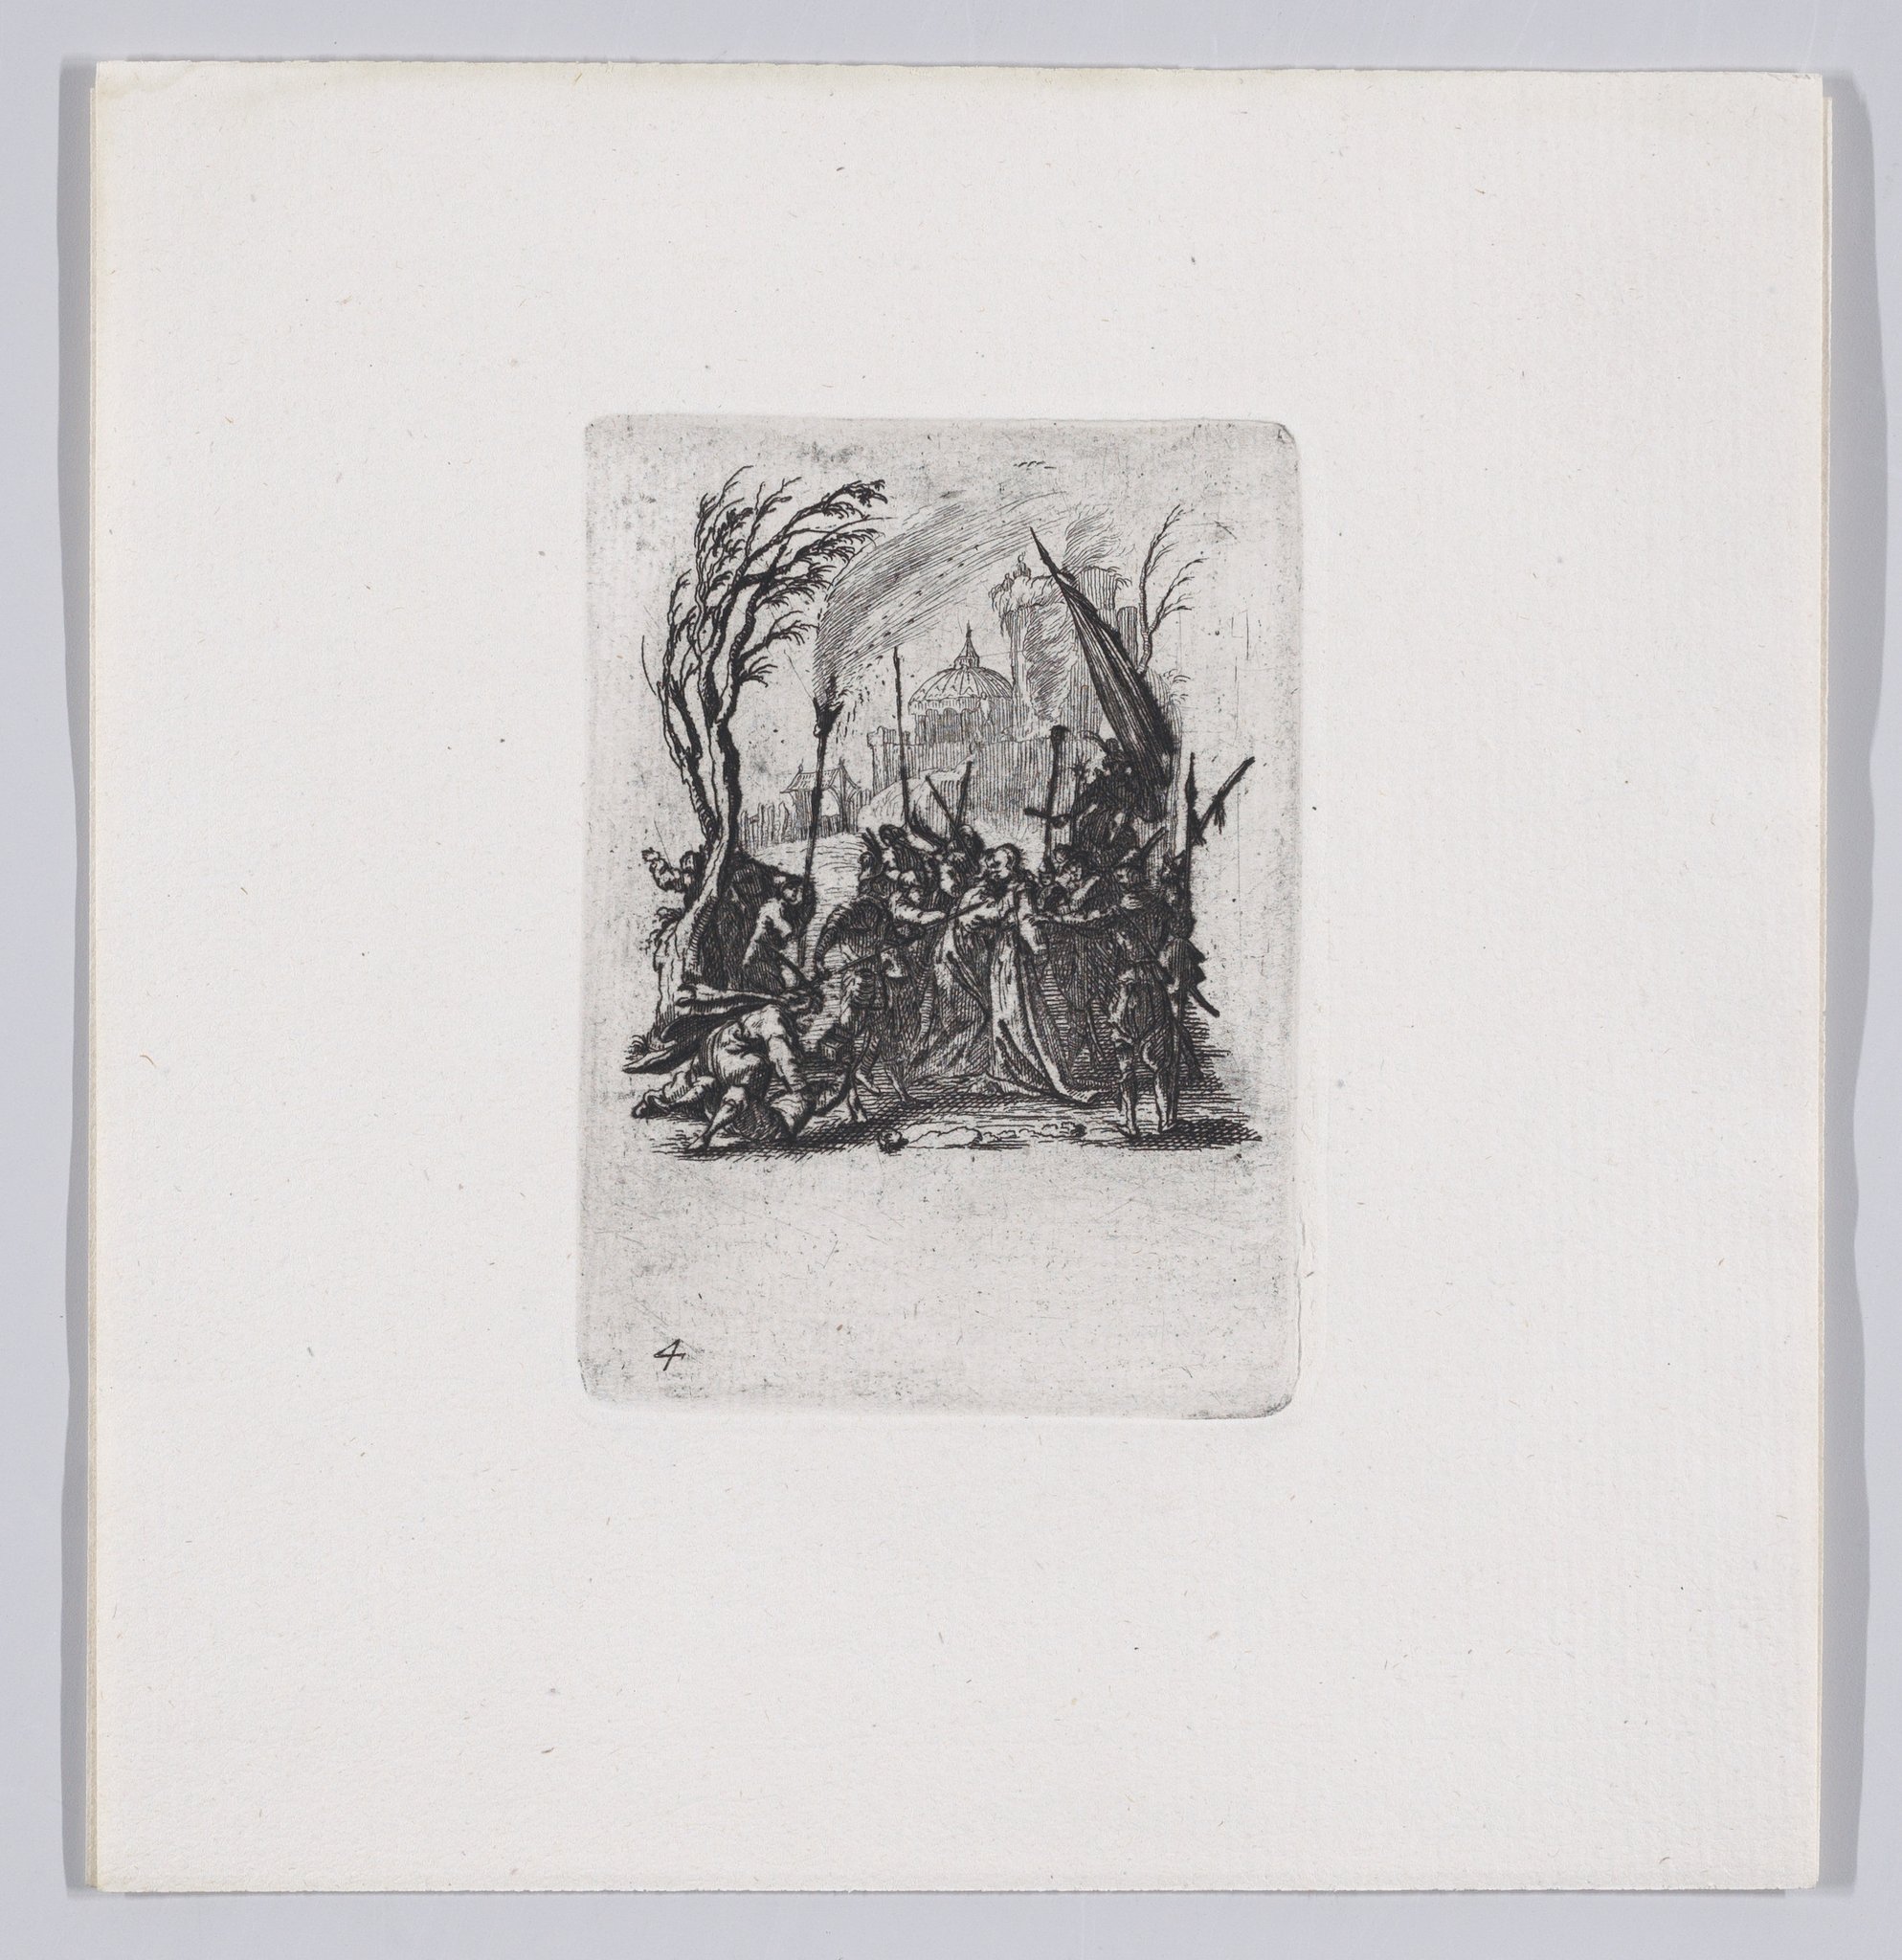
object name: print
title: Reverse Copy of Jesus est Livré aux Juifs (Jesus is Delivered to the Jews), from La Petite Passion (The Little Passion)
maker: Anonymous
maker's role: artist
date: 1601-1700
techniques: etching